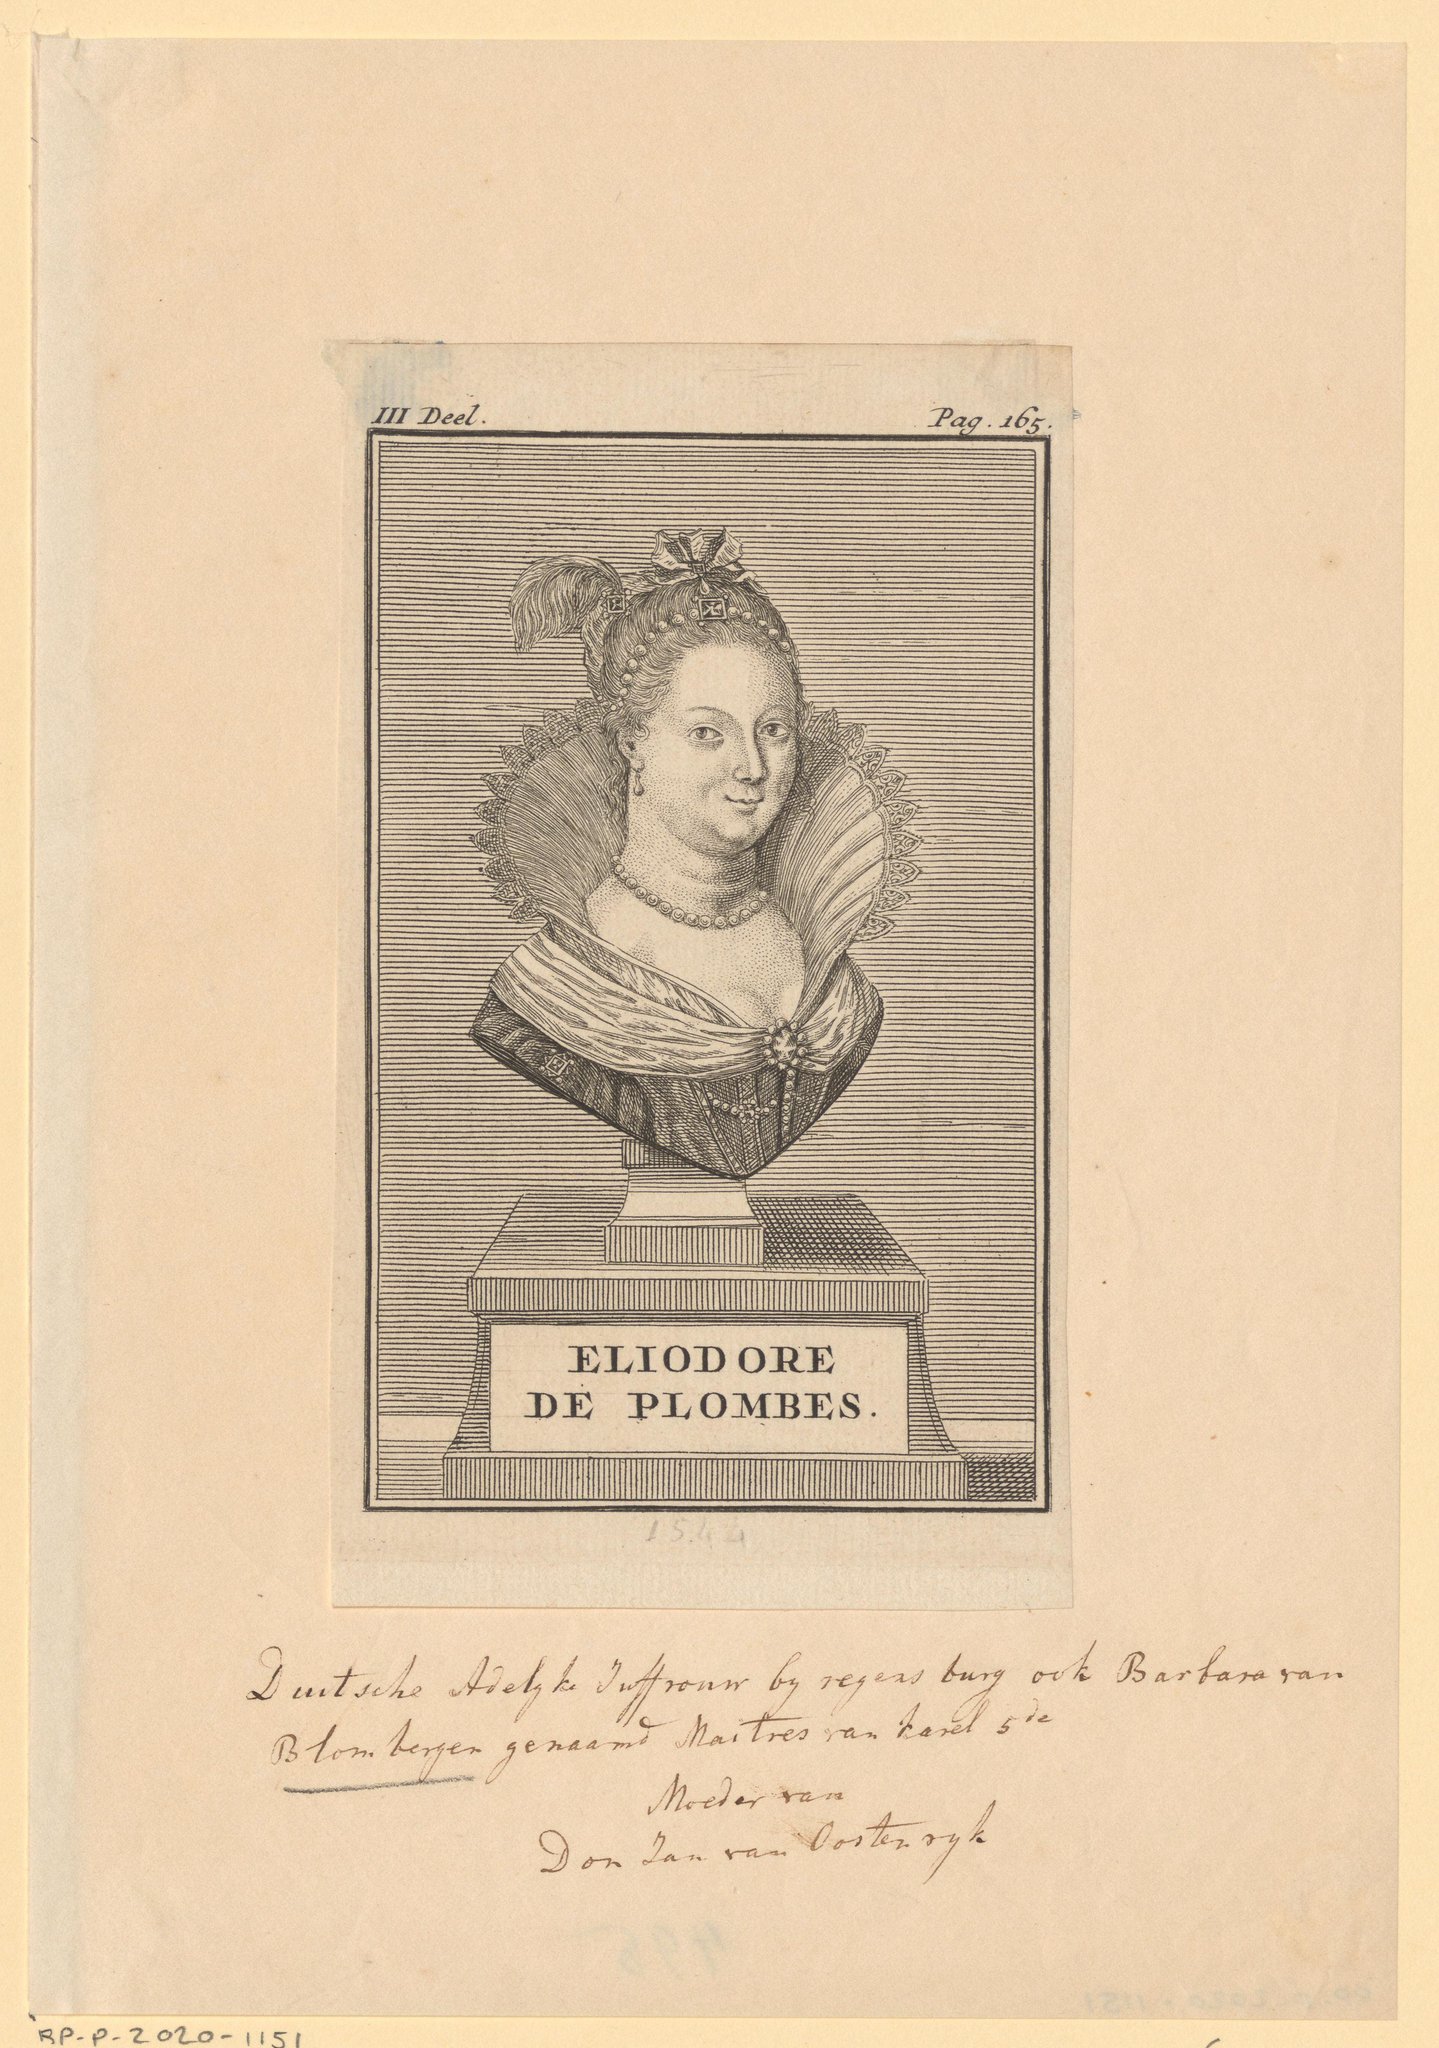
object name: book illustration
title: Portret van Barbara Blomberg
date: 1735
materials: paper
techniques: engraving, etching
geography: amsterdam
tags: historical persons - bb - woman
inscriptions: inscription: ‘Duitsche adelijk juffrouw bij Regensburg (...)’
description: Prent uit: Leti, Gregorio. Het leven van keizer Karel, den Vyfden. Amsterdam: Johannes en Geertrui de Ruyter, 1735, dl. 3. Prent ook verschenen in de tweede editie van 1738.